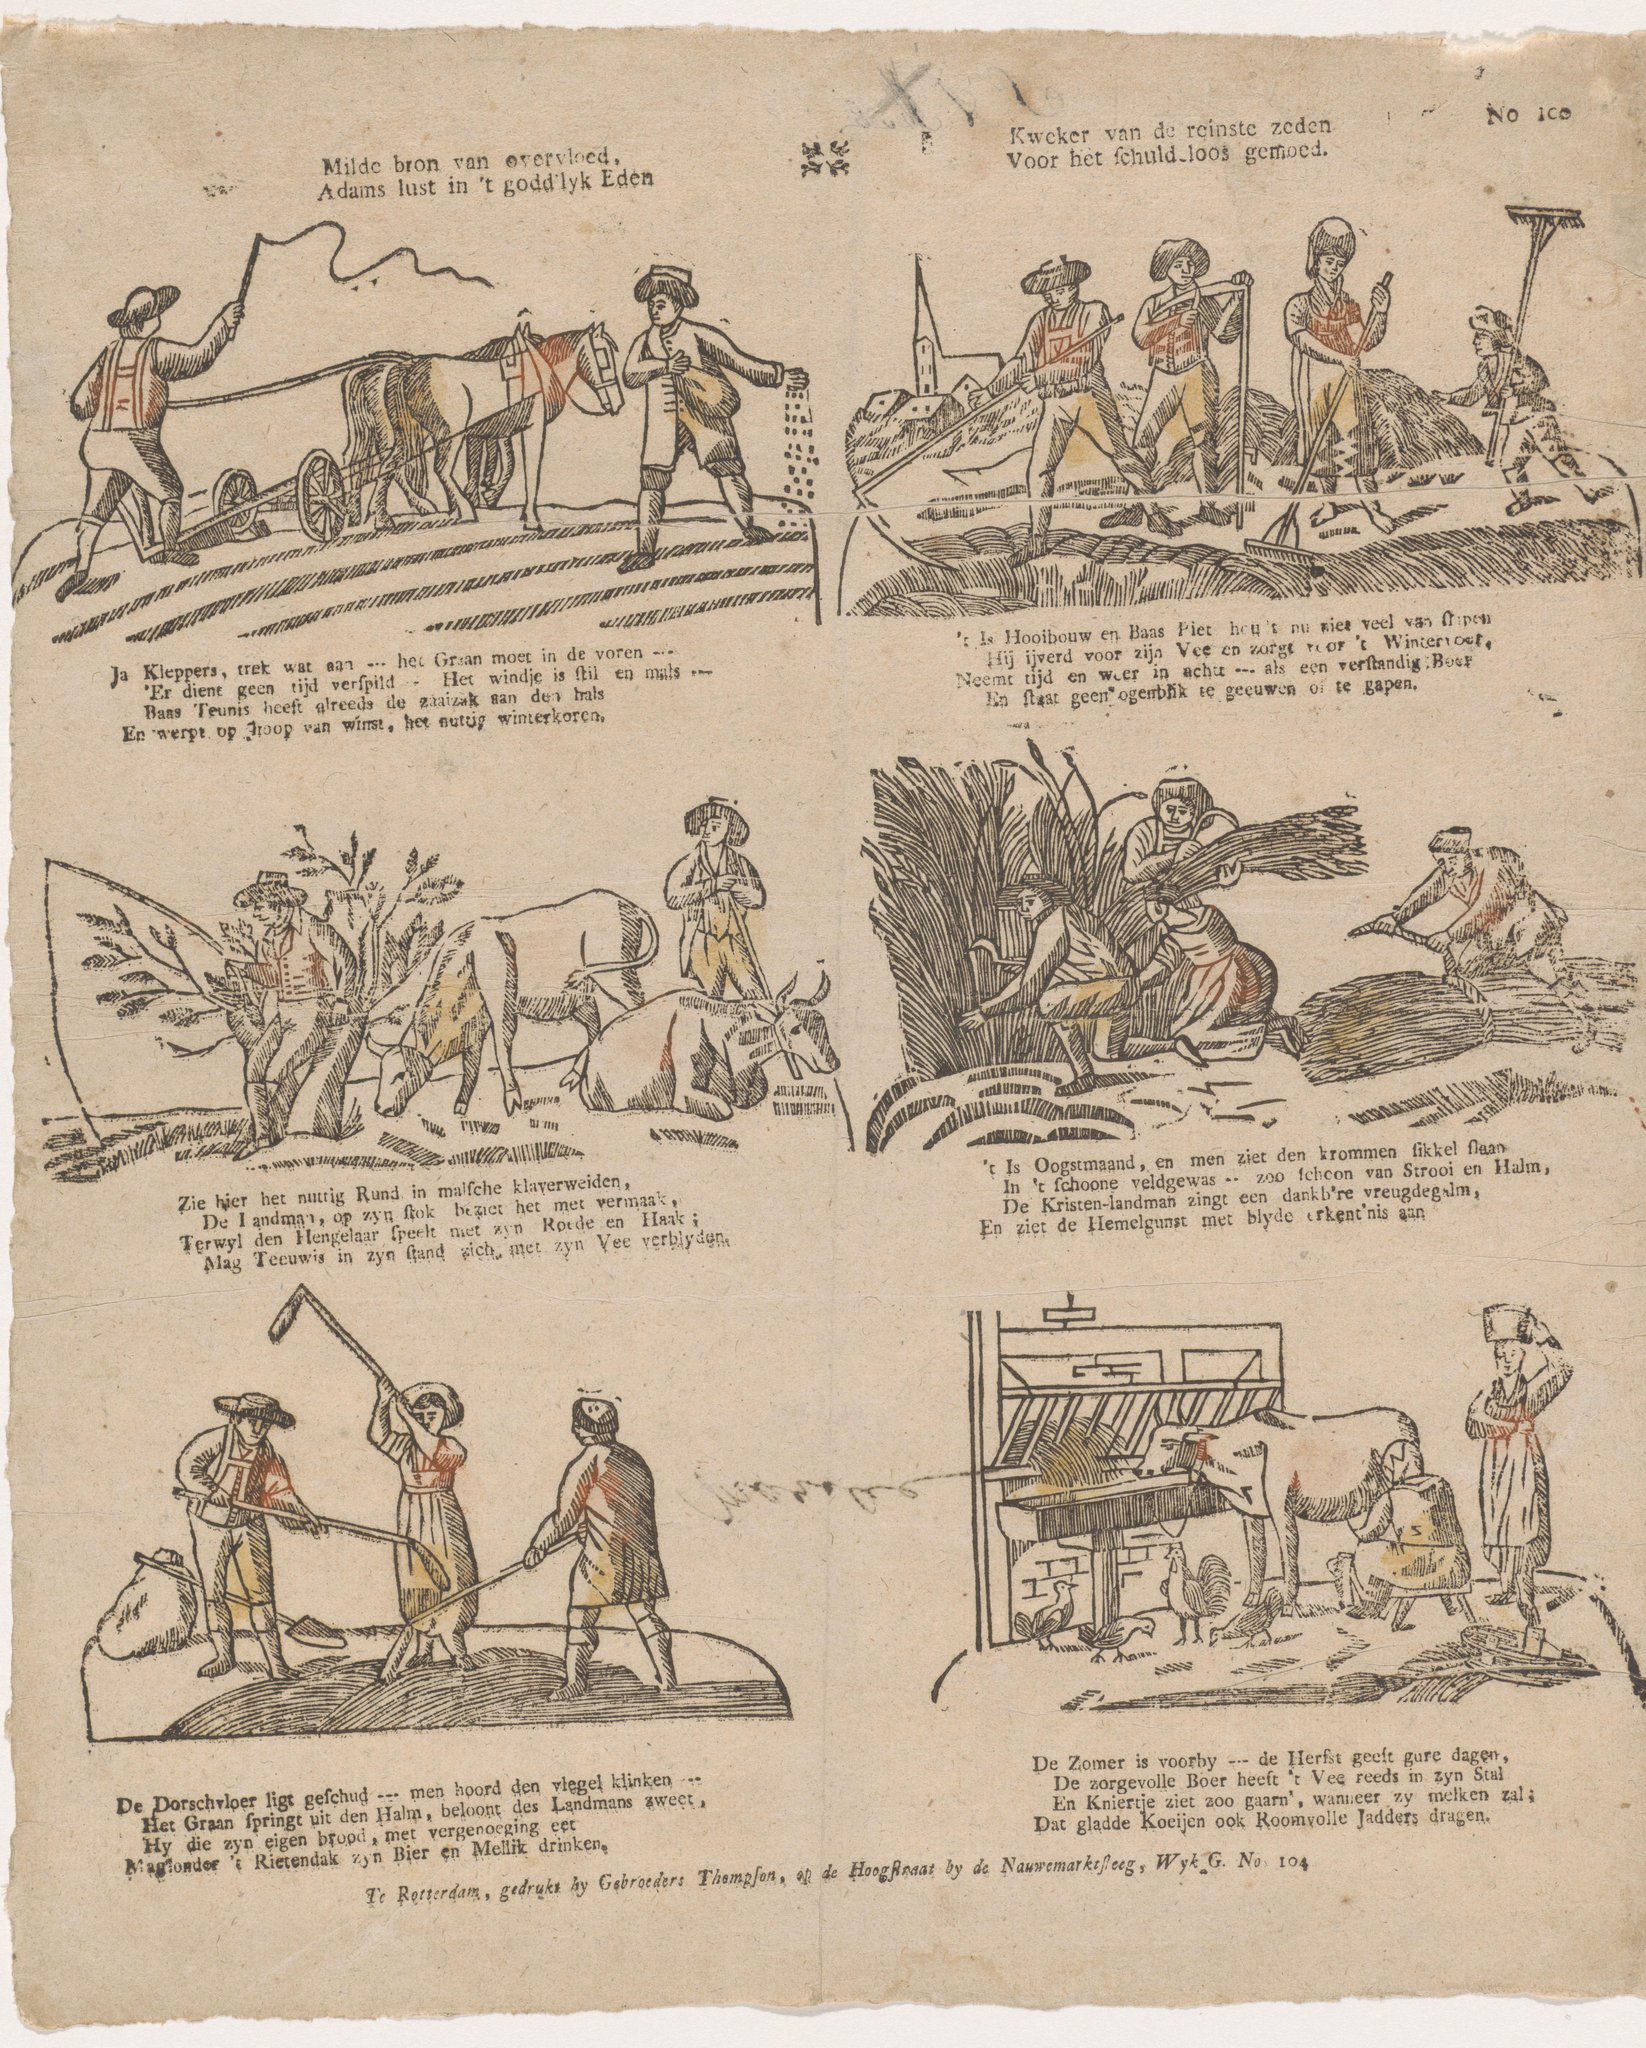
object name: popular print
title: Milde bron van overvloed, / Adams lust in 't godd'lyk Eden / Kweker van de reinste zeden / Voor het schuldeloos gemoed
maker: Anonymous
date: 1825-1829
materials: paper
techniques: colour, letterpress printing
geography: netherlands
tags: farmers, agricultural implements, agriculture, milking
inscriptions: collector's mark: Lugt 2228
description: Blad met 6 voorstellingen van het boerenleven, waaronder boeren die het veld ploegen en zaaien, herders die met koeien in de wei rusten en een boerin die een koe melkt. Onder elke afbeelding een vierregelig vers. Genummerd rechtsboven: No. 100.